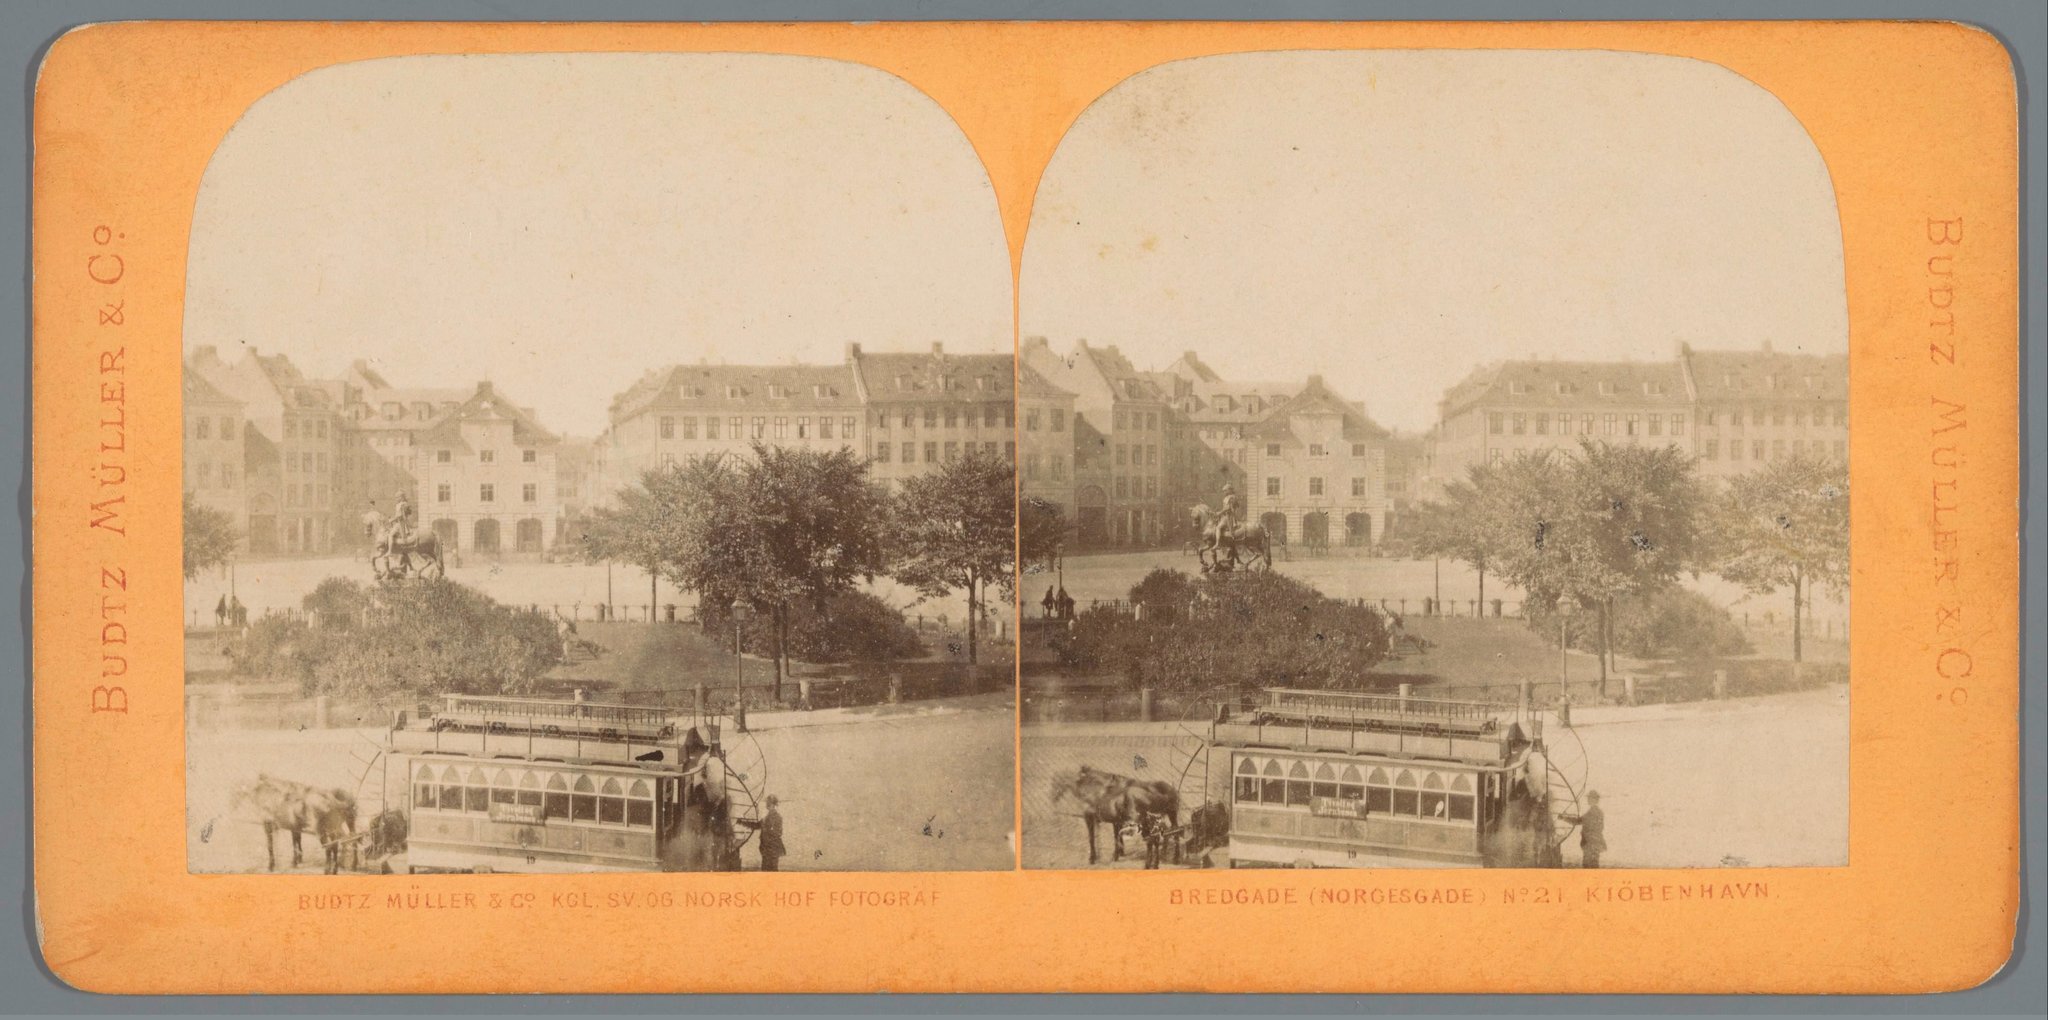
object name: stereograph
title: Gezicht op de Koningsmarkt in Kopenhagen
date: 1873-1890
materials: cardboard, paper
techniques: albumen print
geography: copenhagen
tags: square, place, circus, etc.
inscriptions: address: ‘BREDGADE (NORGESGADE) No. 21 KJÖBENHAVN’